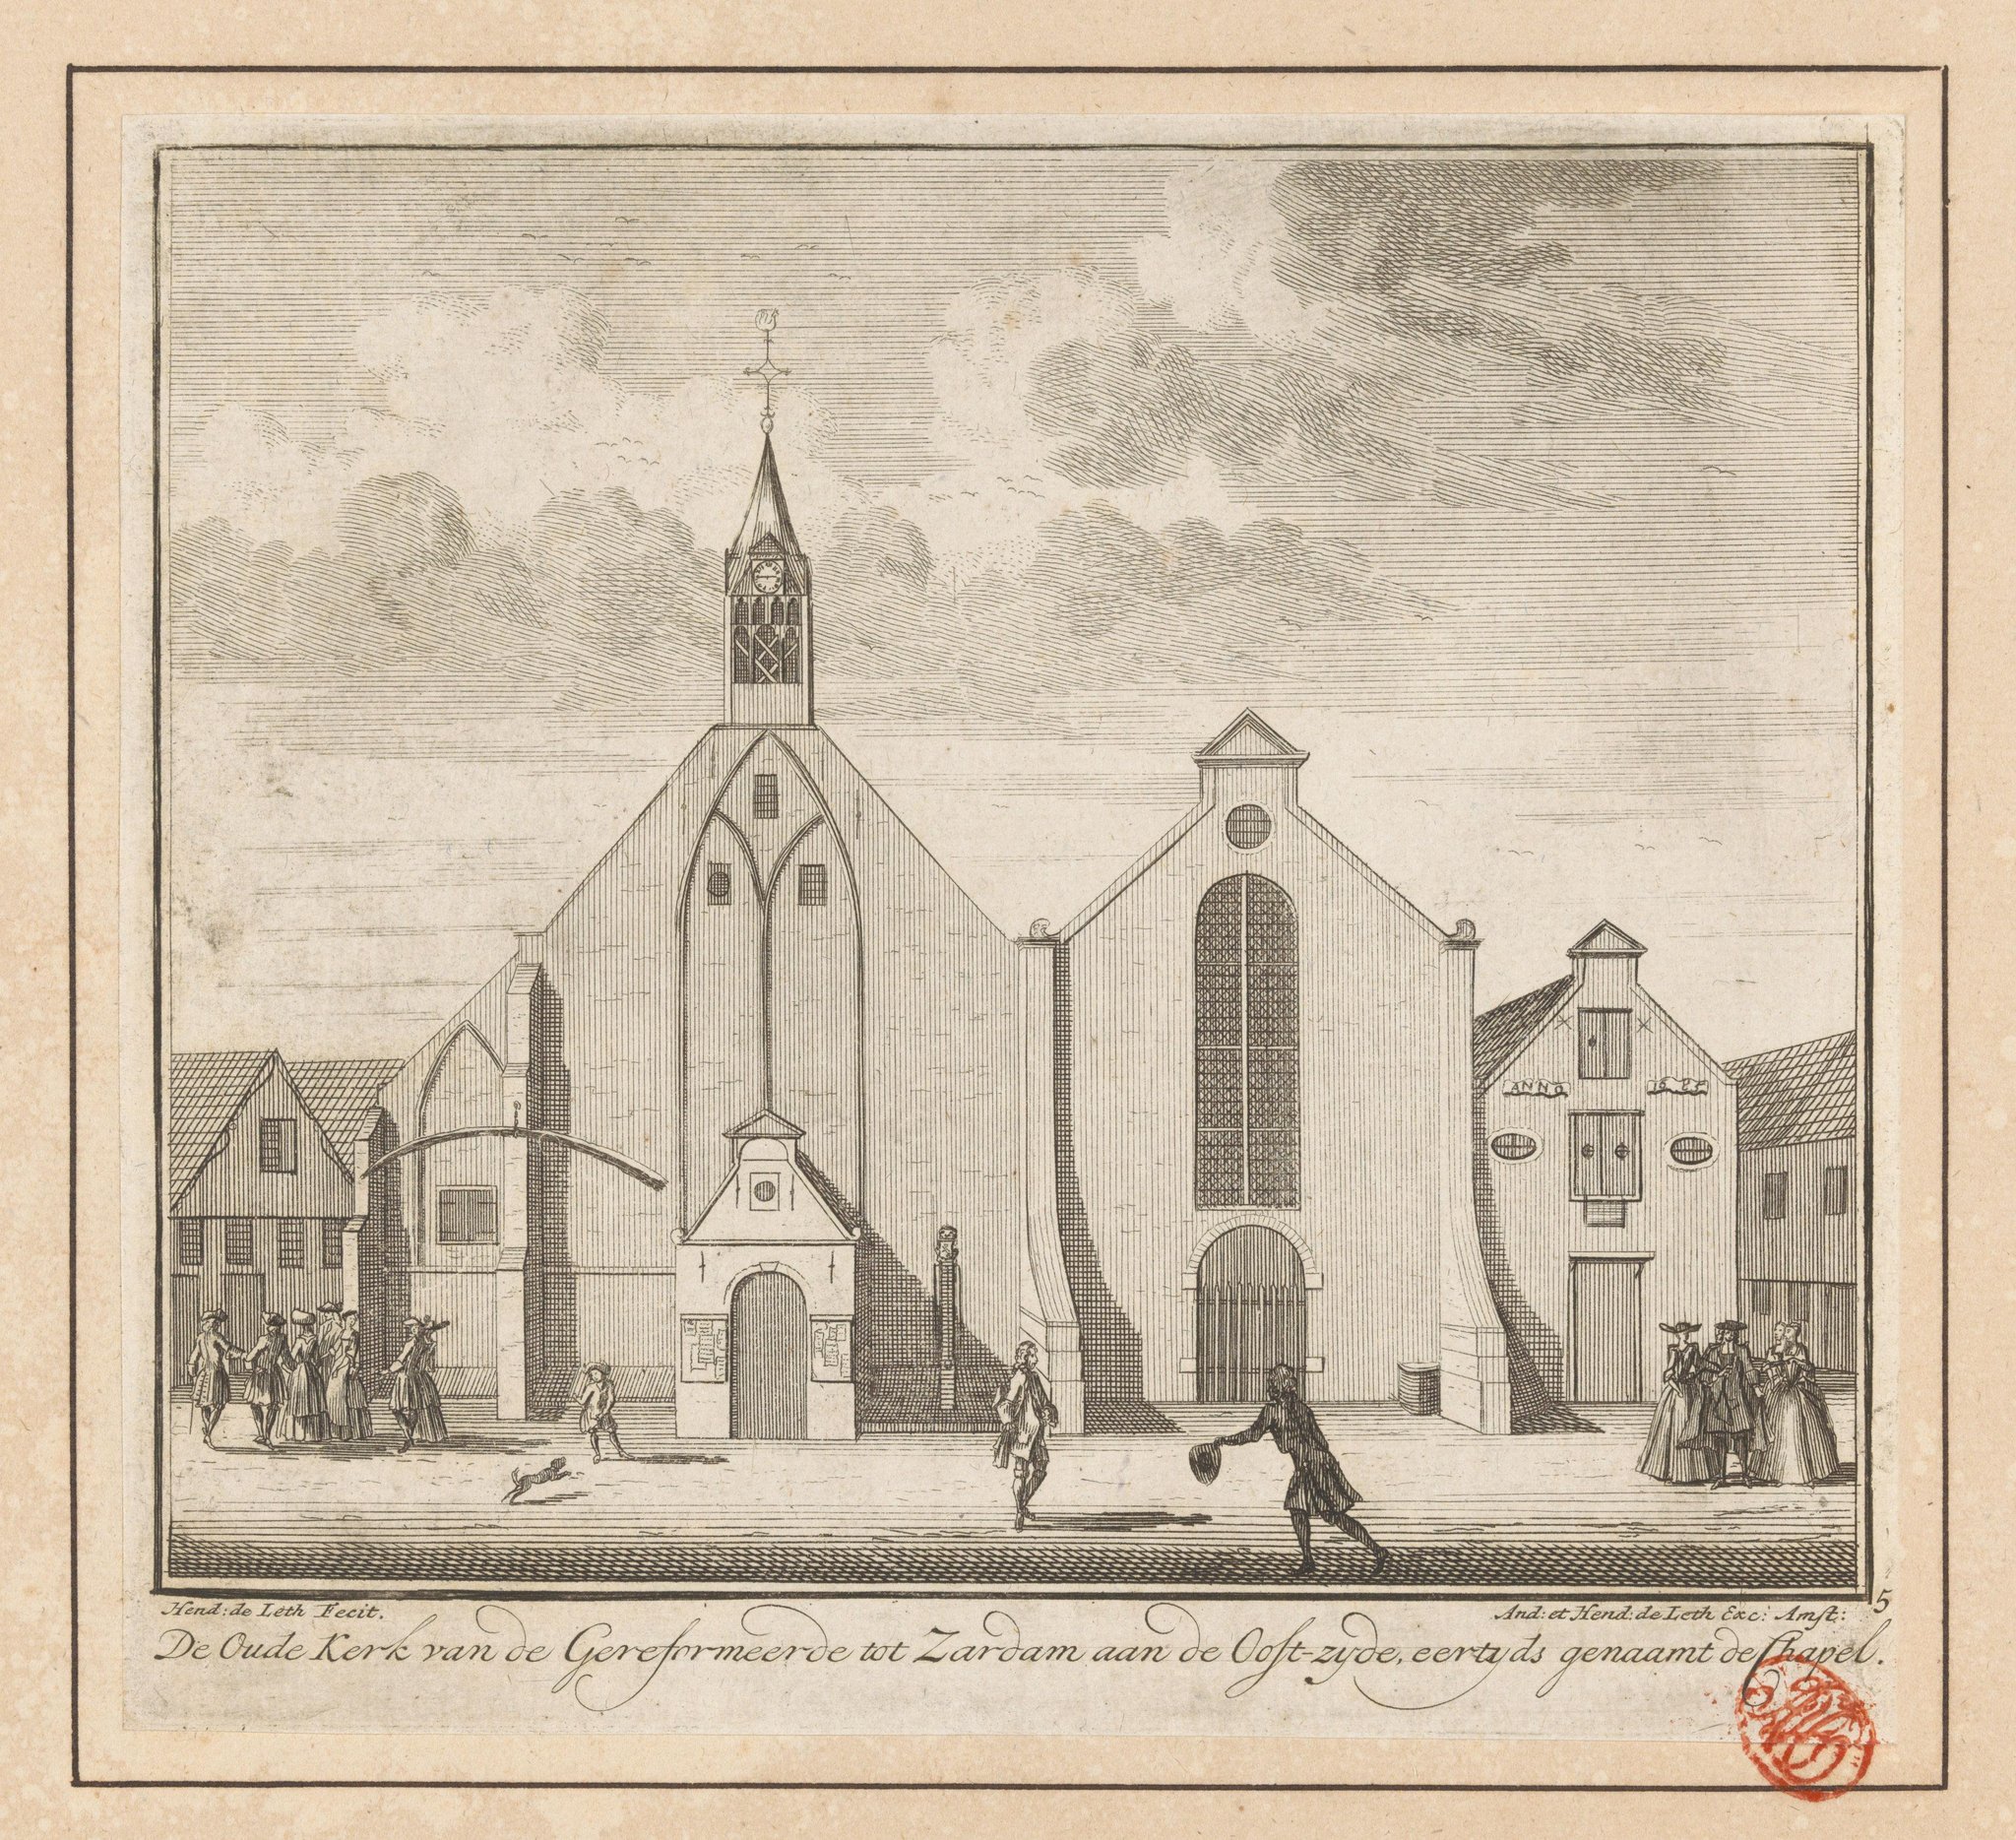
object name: print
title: De Oude Kerk van de Gereformeerde tot Zardam aan de oost-zyde, eertyds genaamt de Chapel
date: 1725-1731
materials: paper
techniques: etching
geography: amsterdam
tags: church (exterior)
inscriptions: collector's mark: Lugt 195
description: Zie ook RP-P-AO-9A-38-2, RP-P-AO-9A-39-1, RP-P-AO-9A-40-1, RP-P-AO-9A-40-2 en RP-P-1921-346.